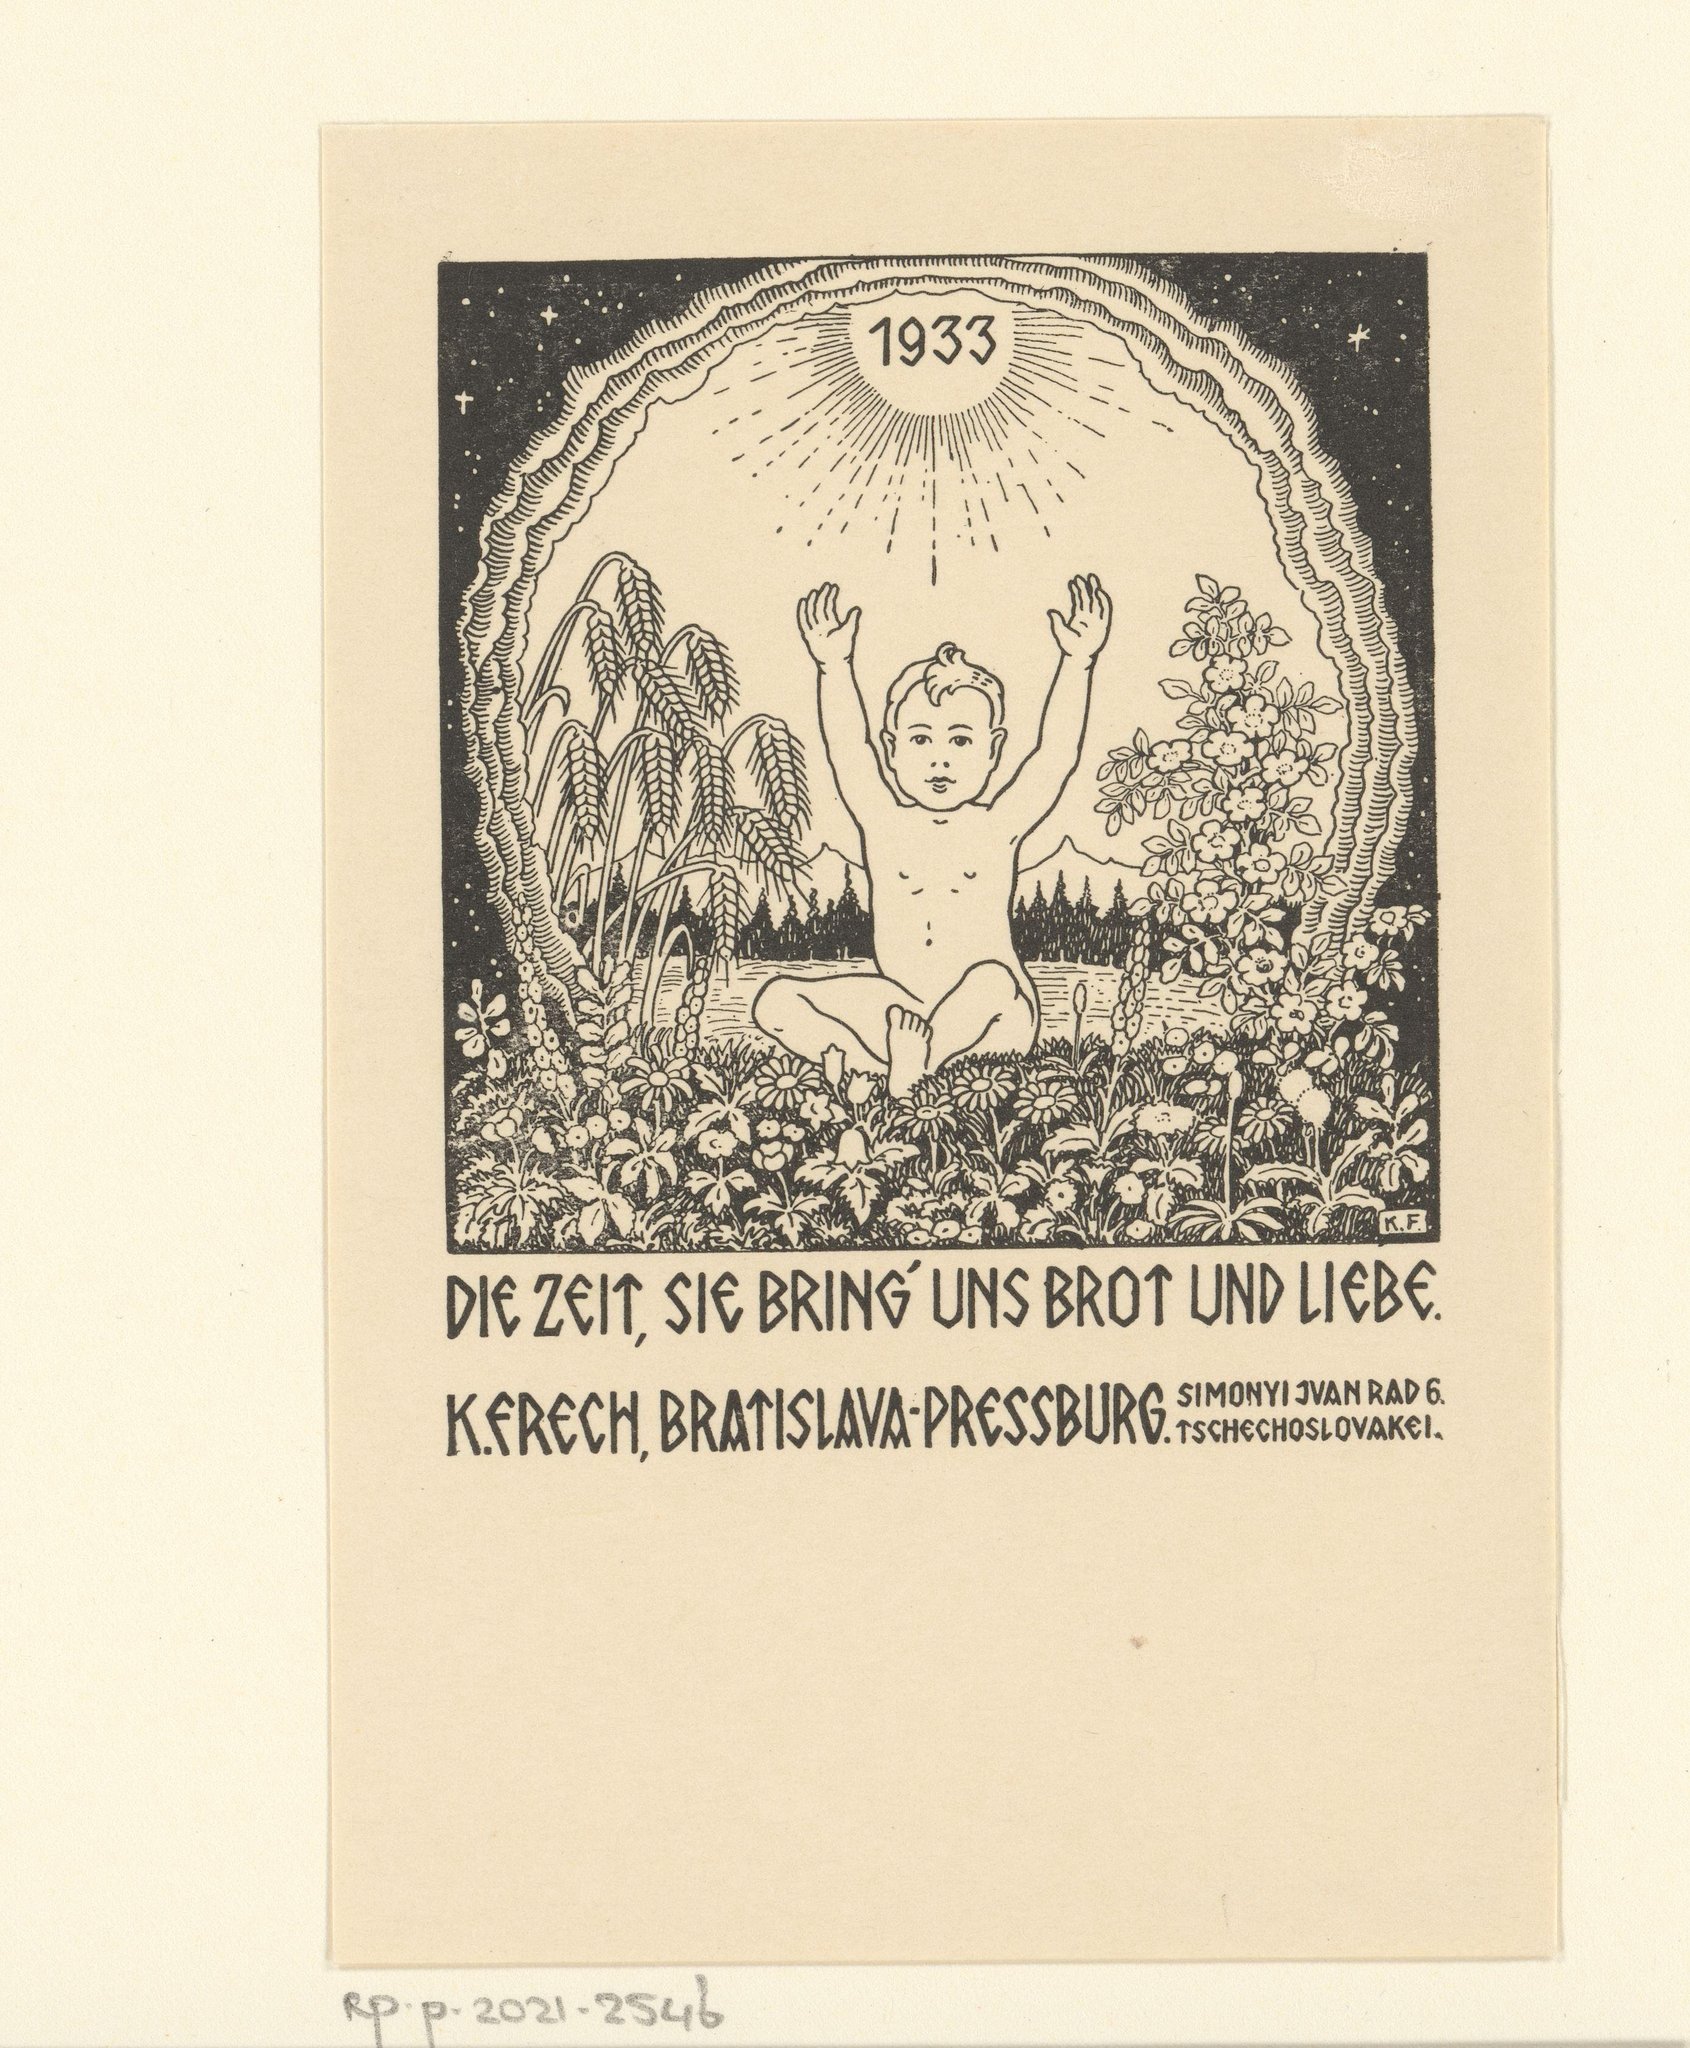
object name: photomechanical print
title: Kerst- en nieuwjaarswens voor 1933 van Karl Hugo Frech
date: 1932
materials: paper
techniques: printing block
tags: print maker, karl hugo frech, flowers, male infant, cereal, grain, corn (grass with grains, grown for food, e.g.: wheat, rice, rye, oats, maize, buckwheat, millet), sitting on the ground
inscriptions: date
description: Een bloot kind zit in het gras tussen bloemen en graan, en reikt op naar de zon waarin het jaartal 1933 staat.